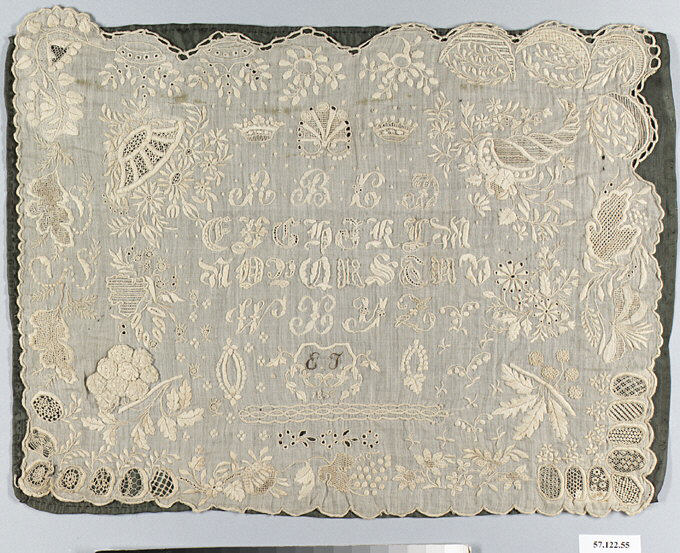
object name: sampler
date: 1852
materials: cotton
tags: flowers